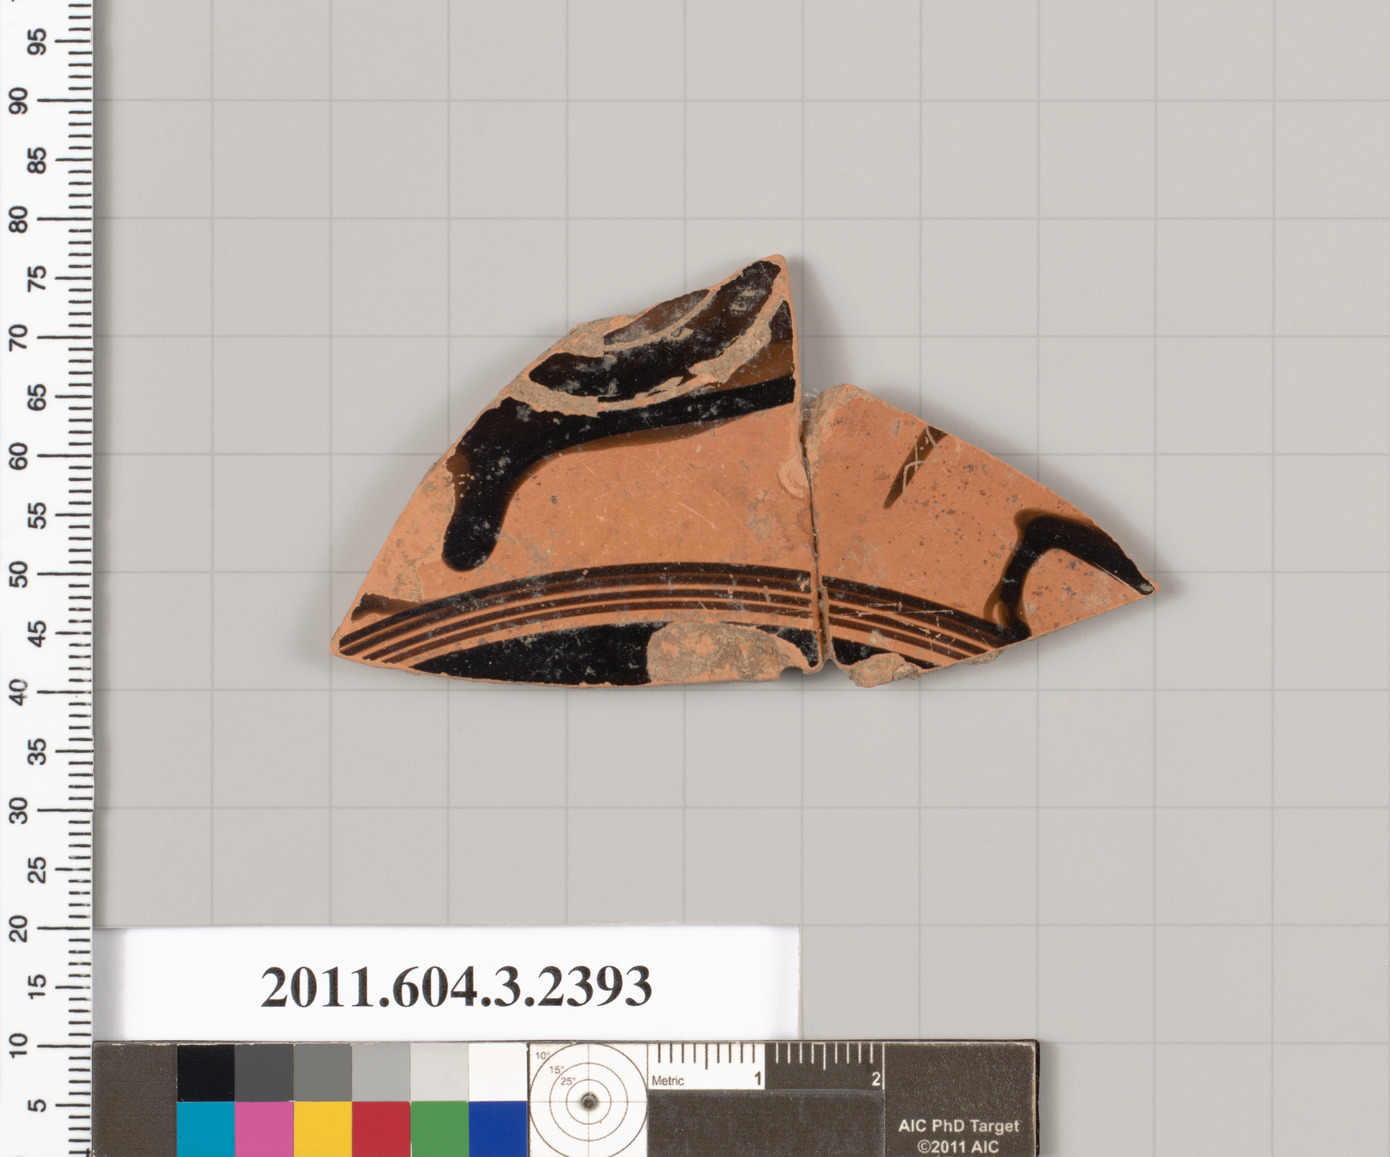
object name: kylix fragment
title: Terracotta fragment of a kylix: eye-cup (drinking cup)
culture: greek, attic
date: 530-510 BCE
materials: terracotta